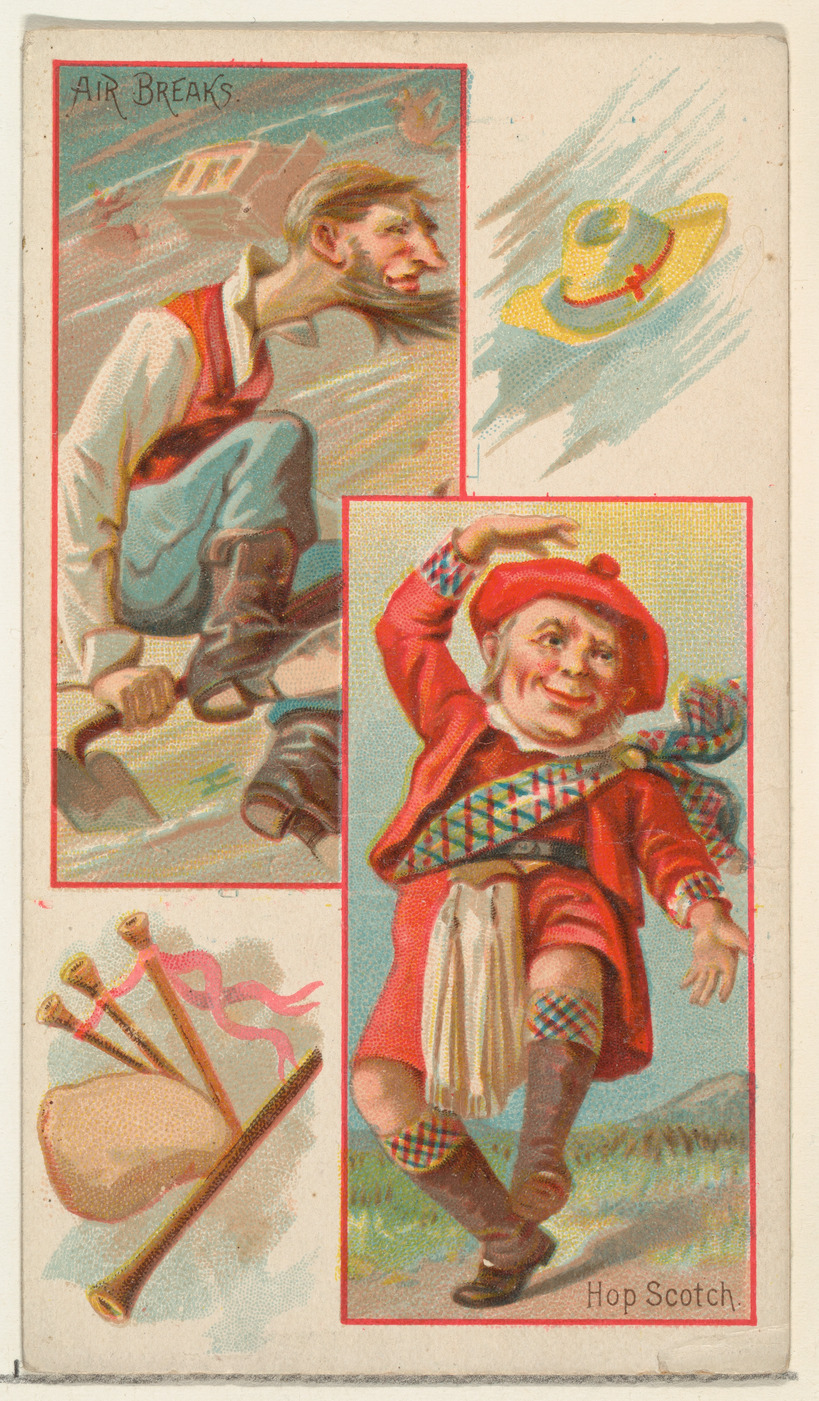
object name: print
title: Air Breaks / Hop Scotch, from the Jokes series (N118) issued by Duke Sons & Co. to promote Honest Long Cut Tobacco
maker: w. duke, sons & co.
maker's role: publisher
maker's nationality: american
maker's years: 1870-1920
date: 1891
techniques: color lithograph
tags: men,dancing,bagpipes